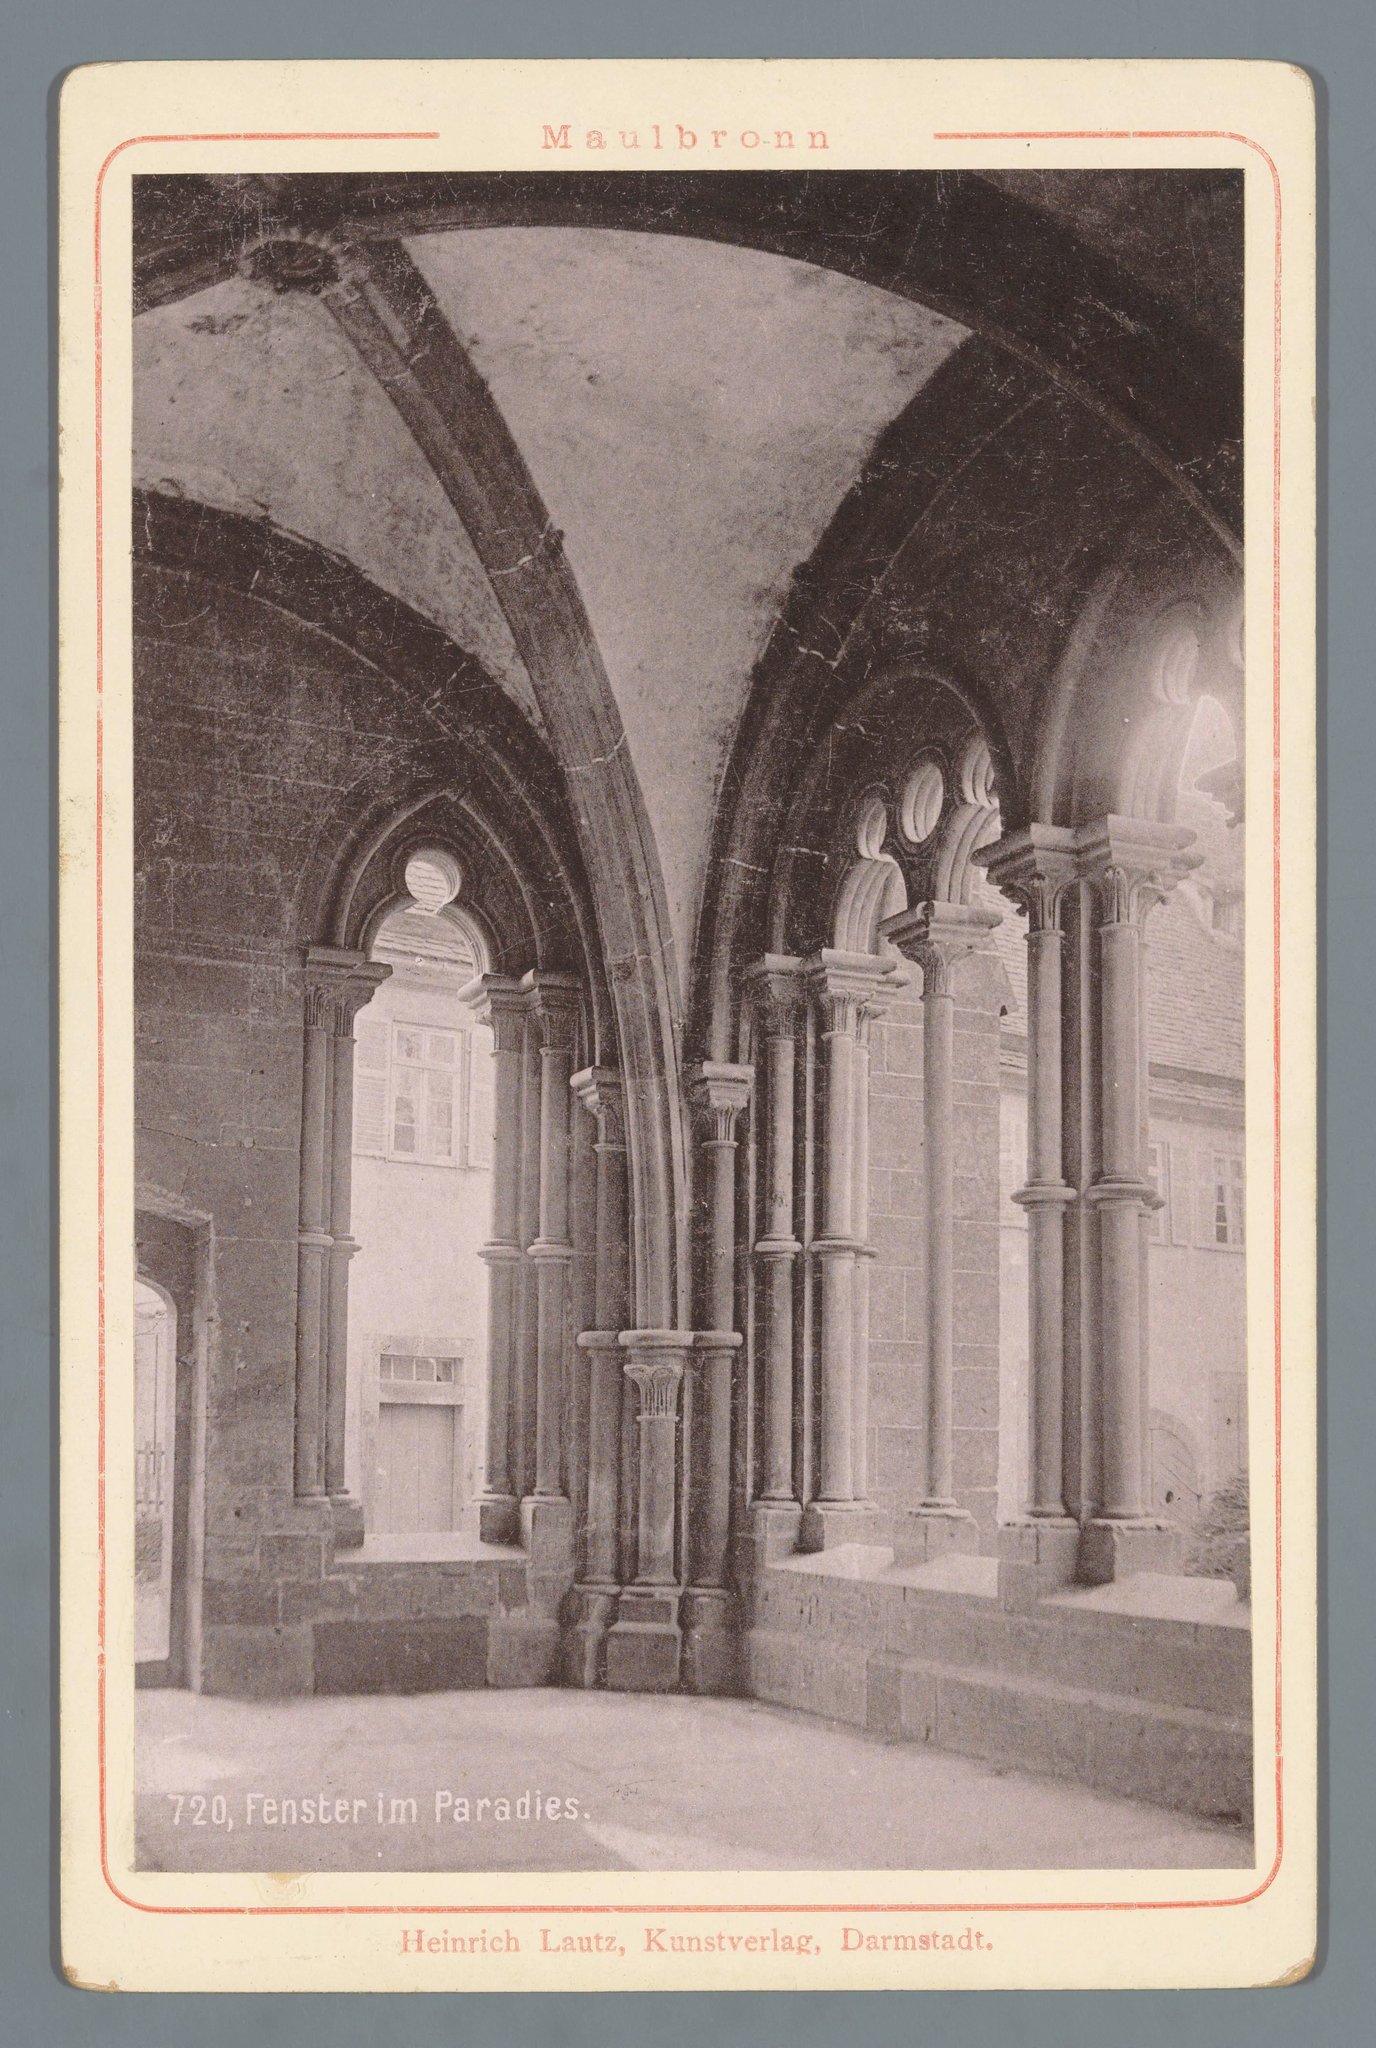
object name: photomechanical print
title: Maulbronn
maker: Anonymous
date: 1895-1900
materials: cardboard, paper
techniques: photograph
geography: maulbronn abbey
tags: church-window, e.g. rose-window, abbey, monastery, convent ~ roman catholic church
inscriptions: number: ‘720’, inscription: ‘17 Juli 1894.’